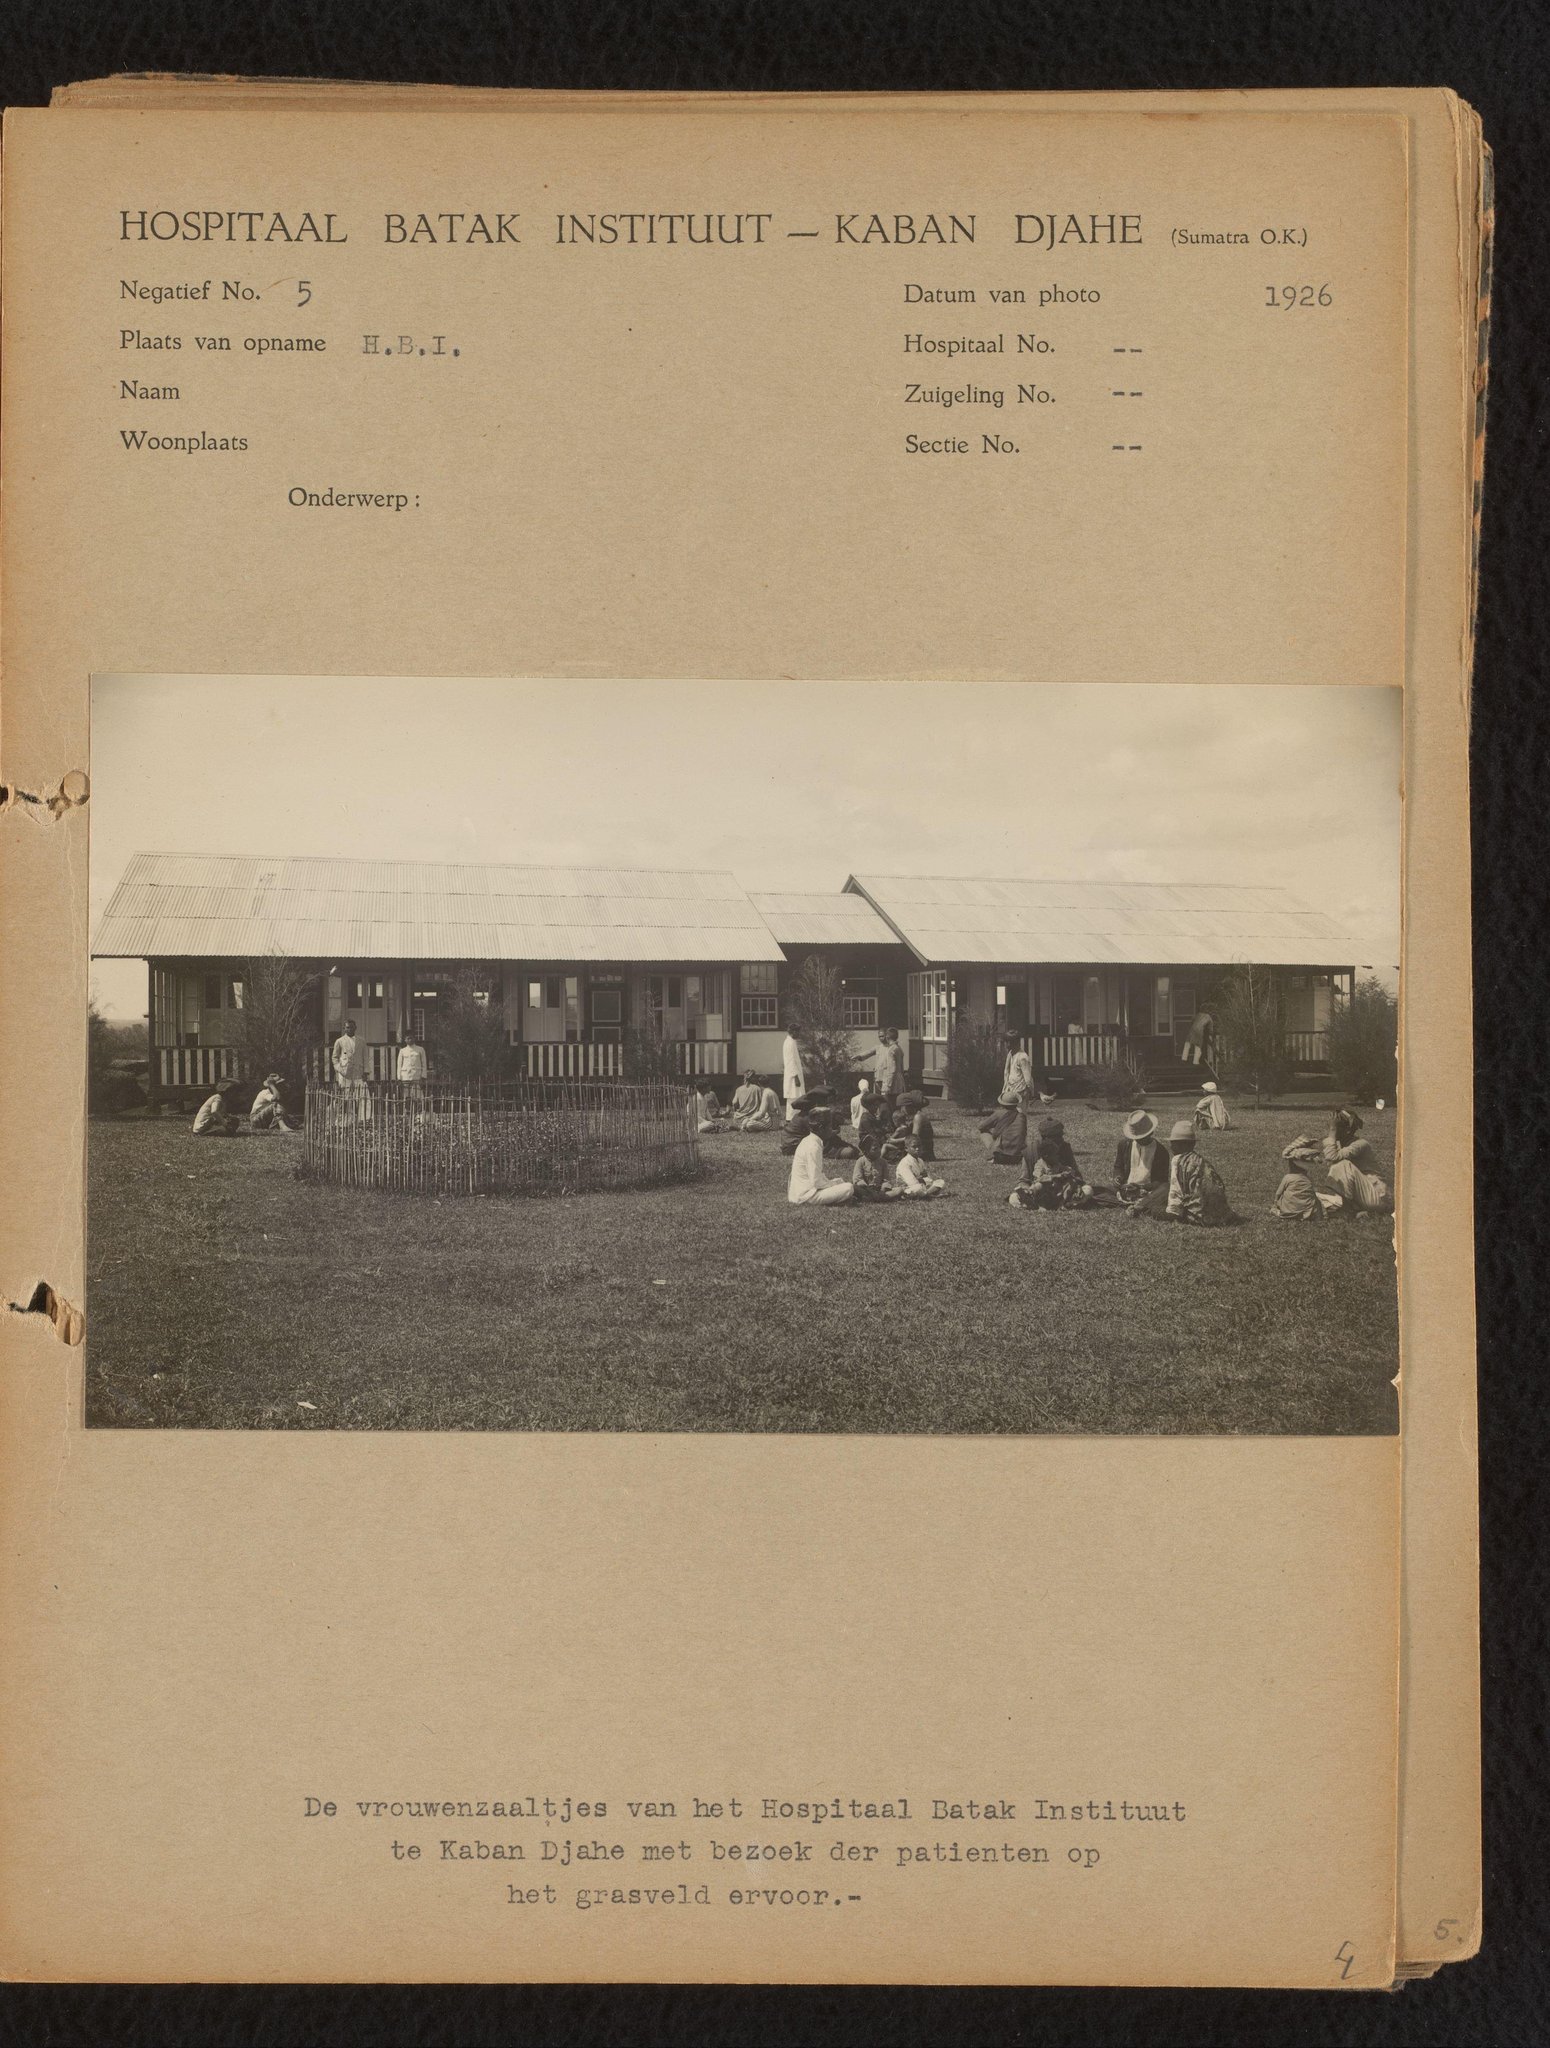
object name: photograph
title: De vrouwenzaaltjes van het Hospitaal Batak Instituut te Kaban Djahe met bezoek der patienten op het grasveld ervoor.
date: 1926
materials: cardboard, photographic support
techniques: gelatin silver print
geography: kabanjahe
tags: colonial system, ward; room (in hospital), sumatra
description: Gezicht op de gebouwen bestemd voor vrouwelijke patienten. Op de voorgrond een grasveld waar de patienten zitten met bezoekers. Datum foto: 1926. Foto geplakt op voorgedrukt kartonnen blad ingebonden in het fotoalbum over het Hospitaal Batak Instituut te Kabanjaheh op Sumatra in de jaren 1926-1929.